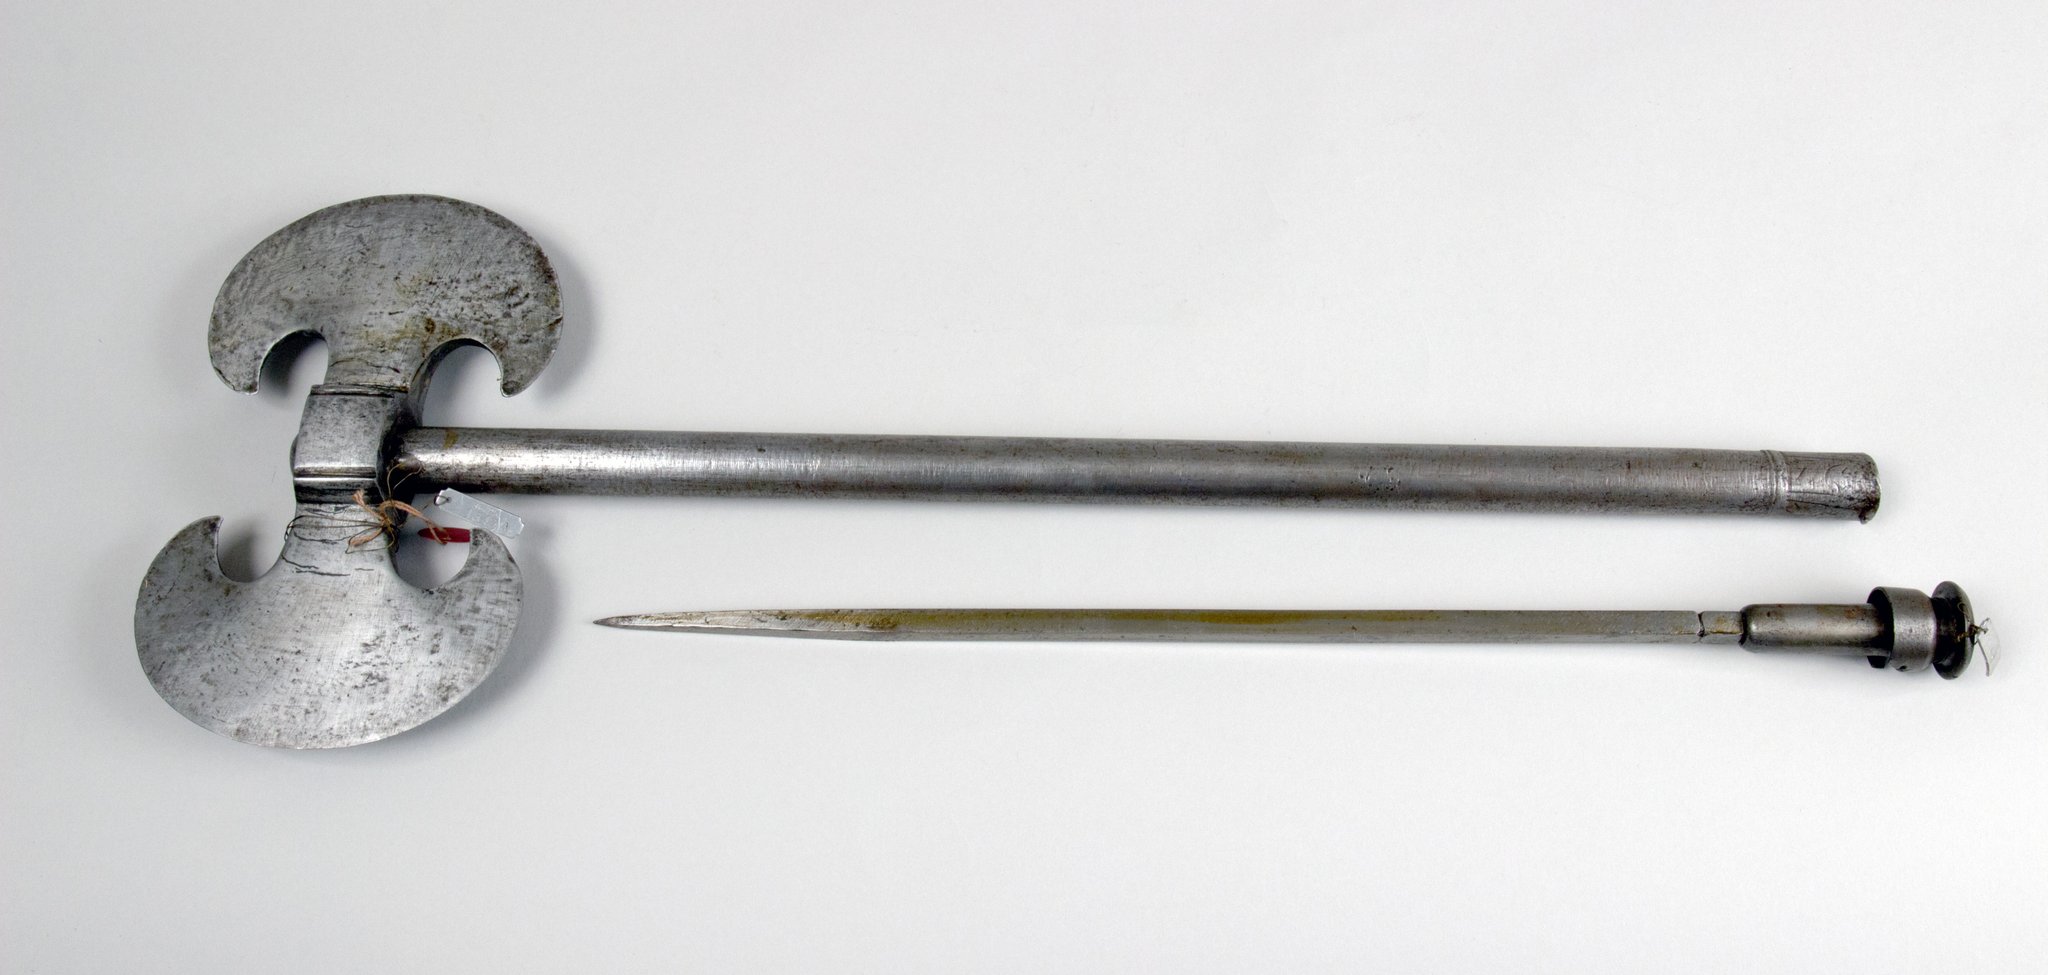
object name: axe with stiletto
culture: indian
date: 1701-1900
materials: steel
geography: india